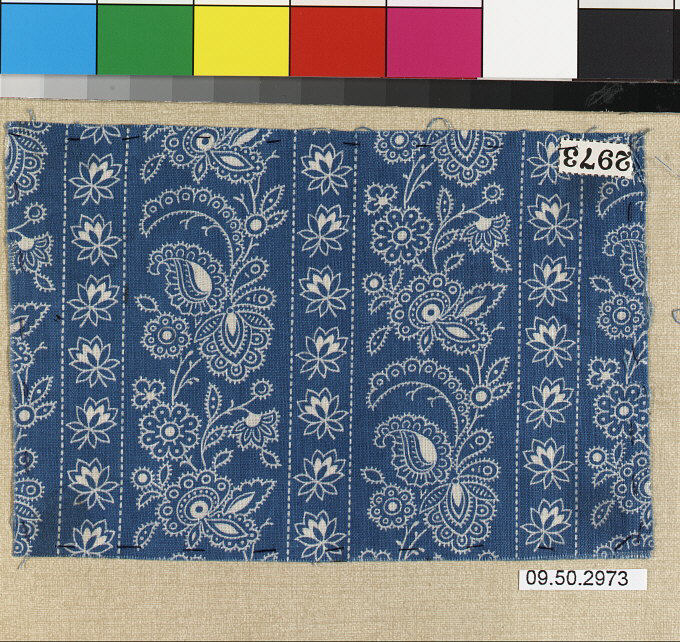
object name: piece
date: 1801-1900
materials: cotton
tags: flowers,leaves